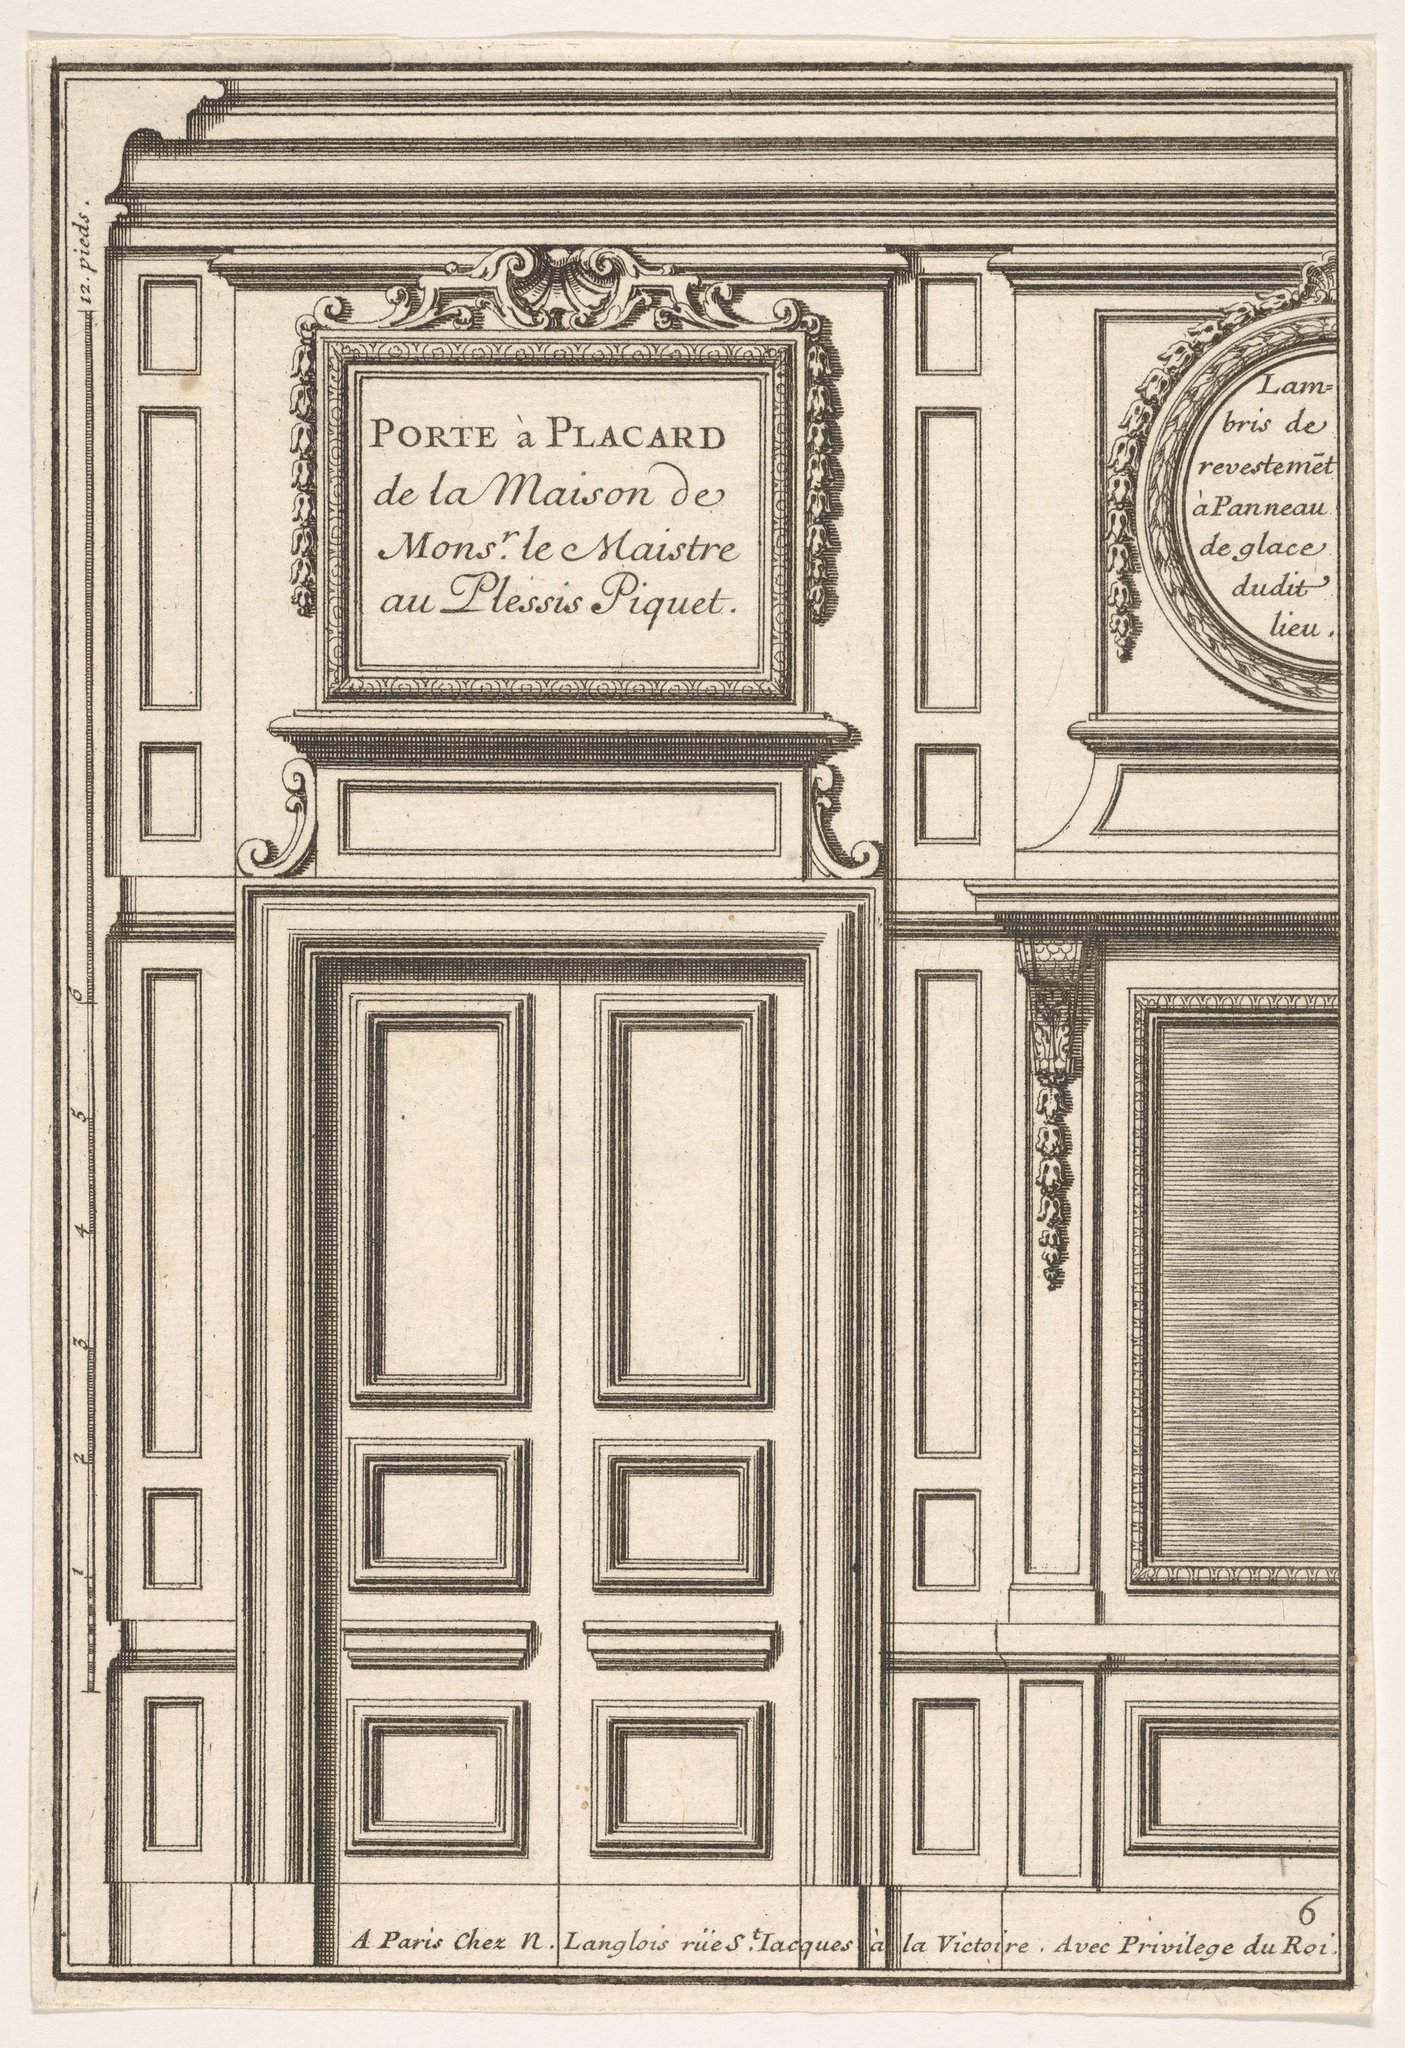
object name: print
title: Door and Part of the Wall Paneling with Mirrored Glass from the House of Monsieur le Maître at Plessis Piquet, plate VI from "Portes a Placard et Lambris"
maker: jean le pautre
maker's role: etcher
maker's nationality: french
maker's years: 1618-1682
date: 1601-1700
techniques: etching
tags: architecture,doors